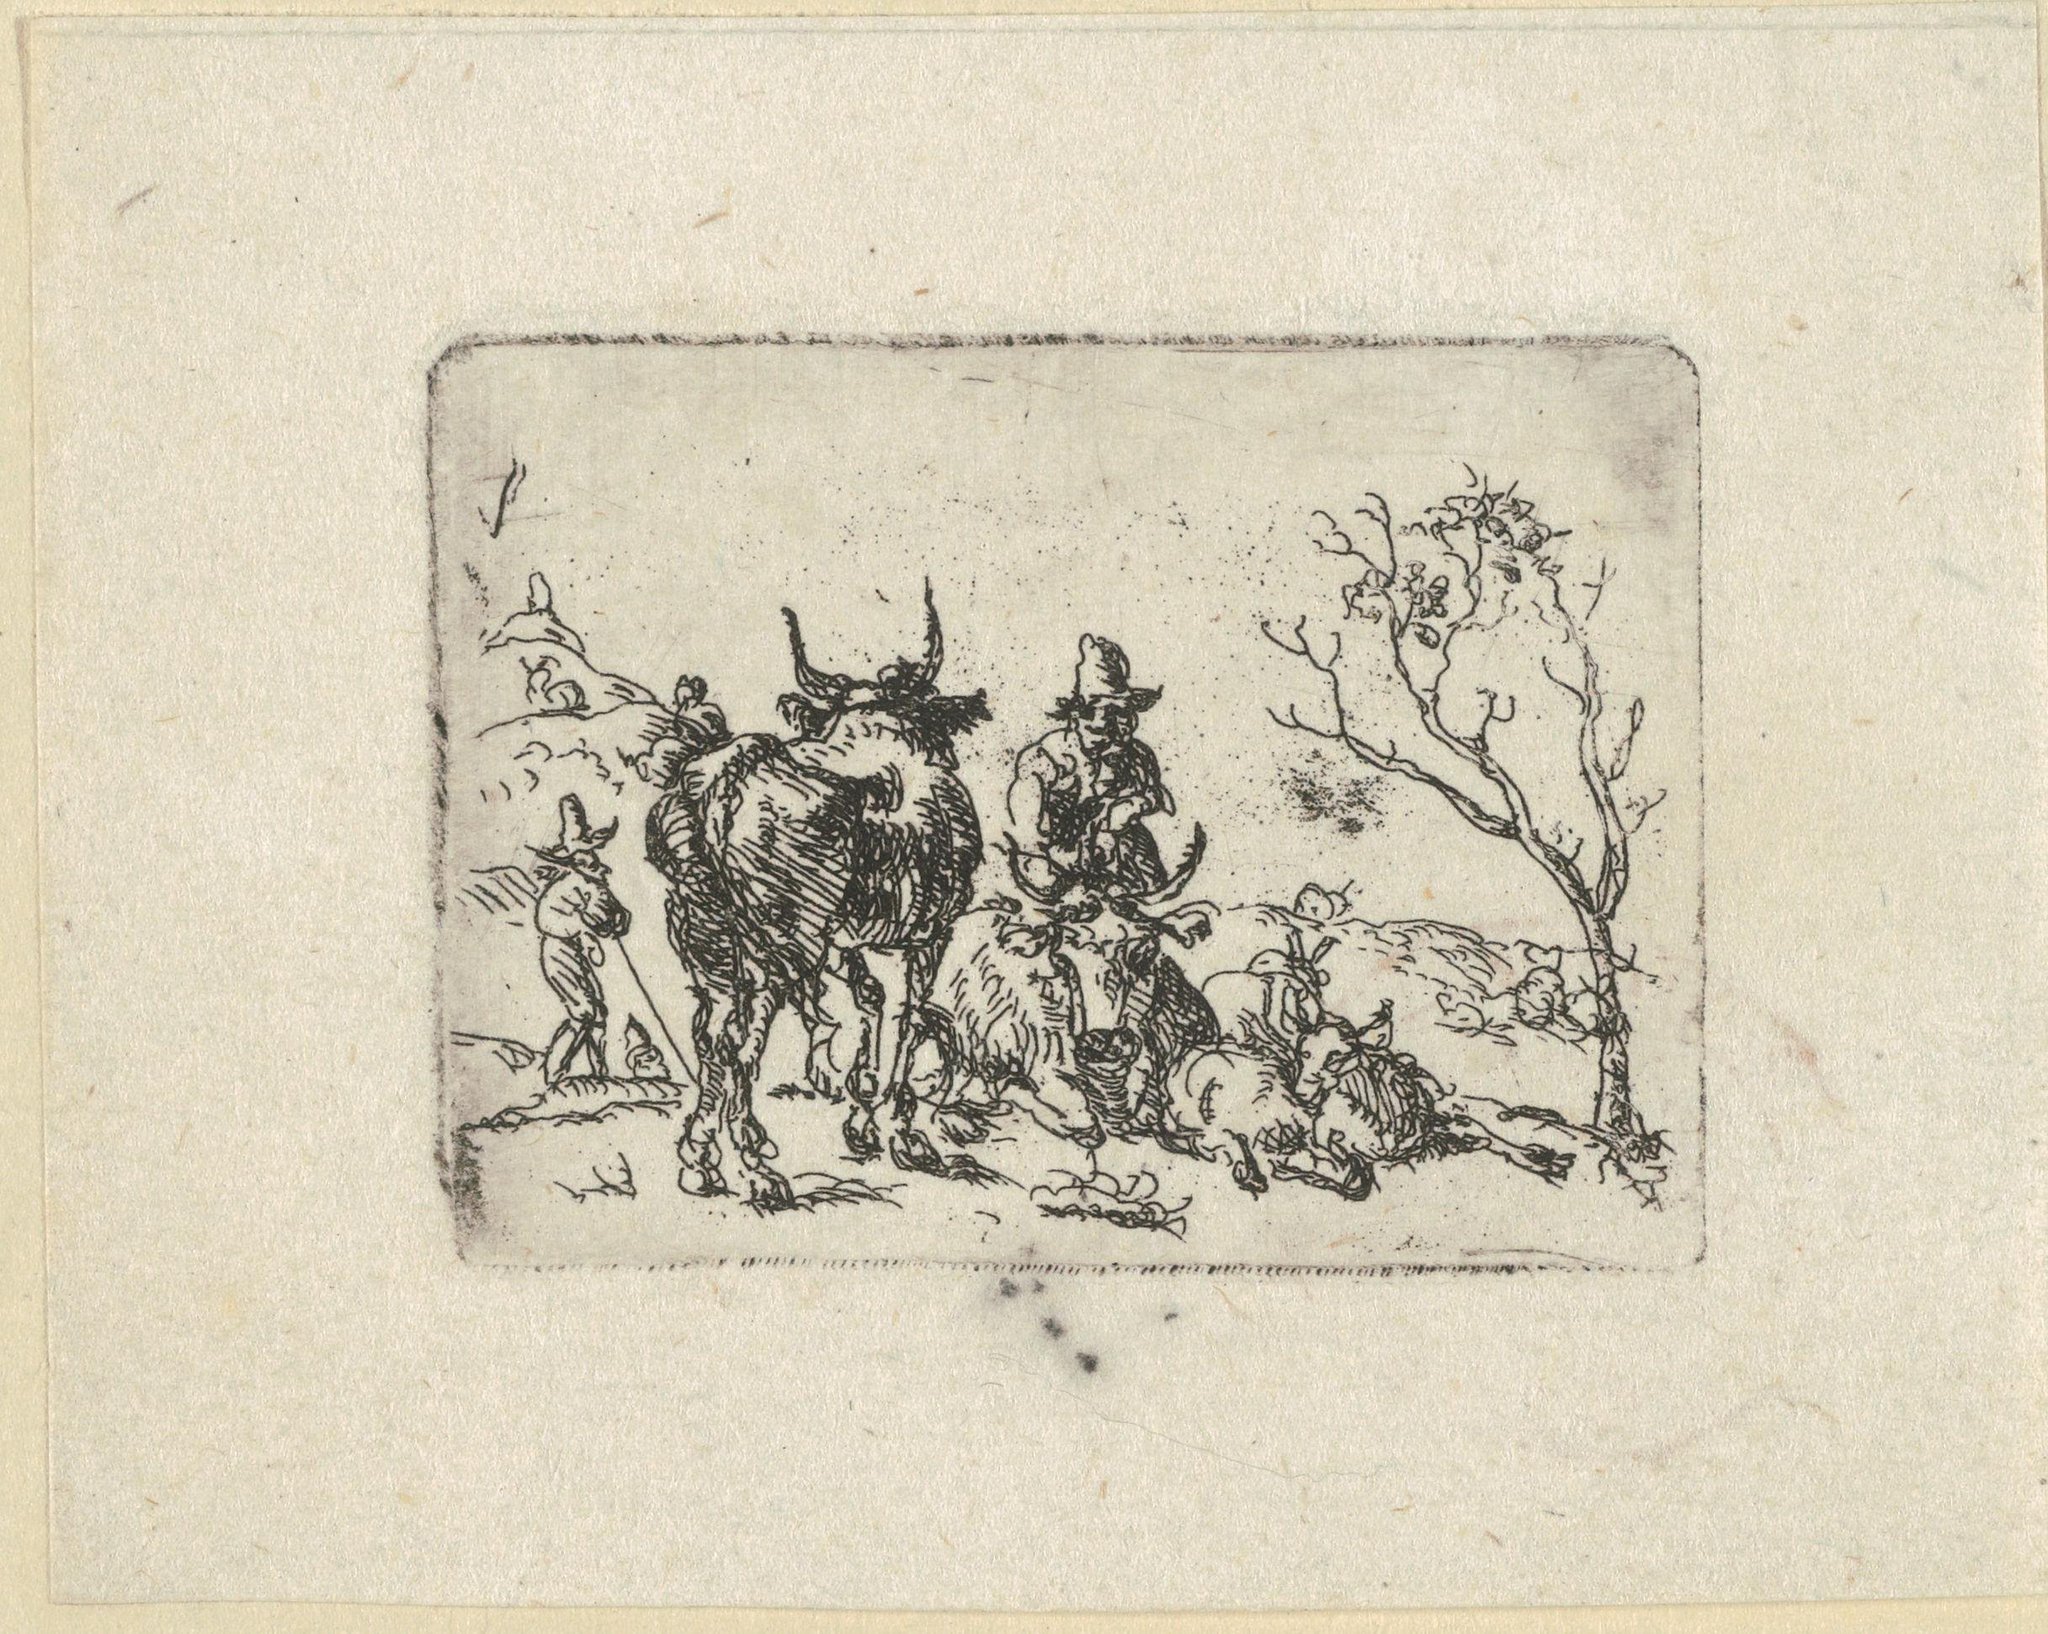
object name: print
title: Twee herders bij hun vee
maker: Anonymous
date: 1600-1700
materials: paper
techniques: etching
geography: netherlands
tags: herding, herdsman, herdswoman, shepherd, shepherdess, cowherd, etc.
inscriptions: collector's mark: Lugt 240